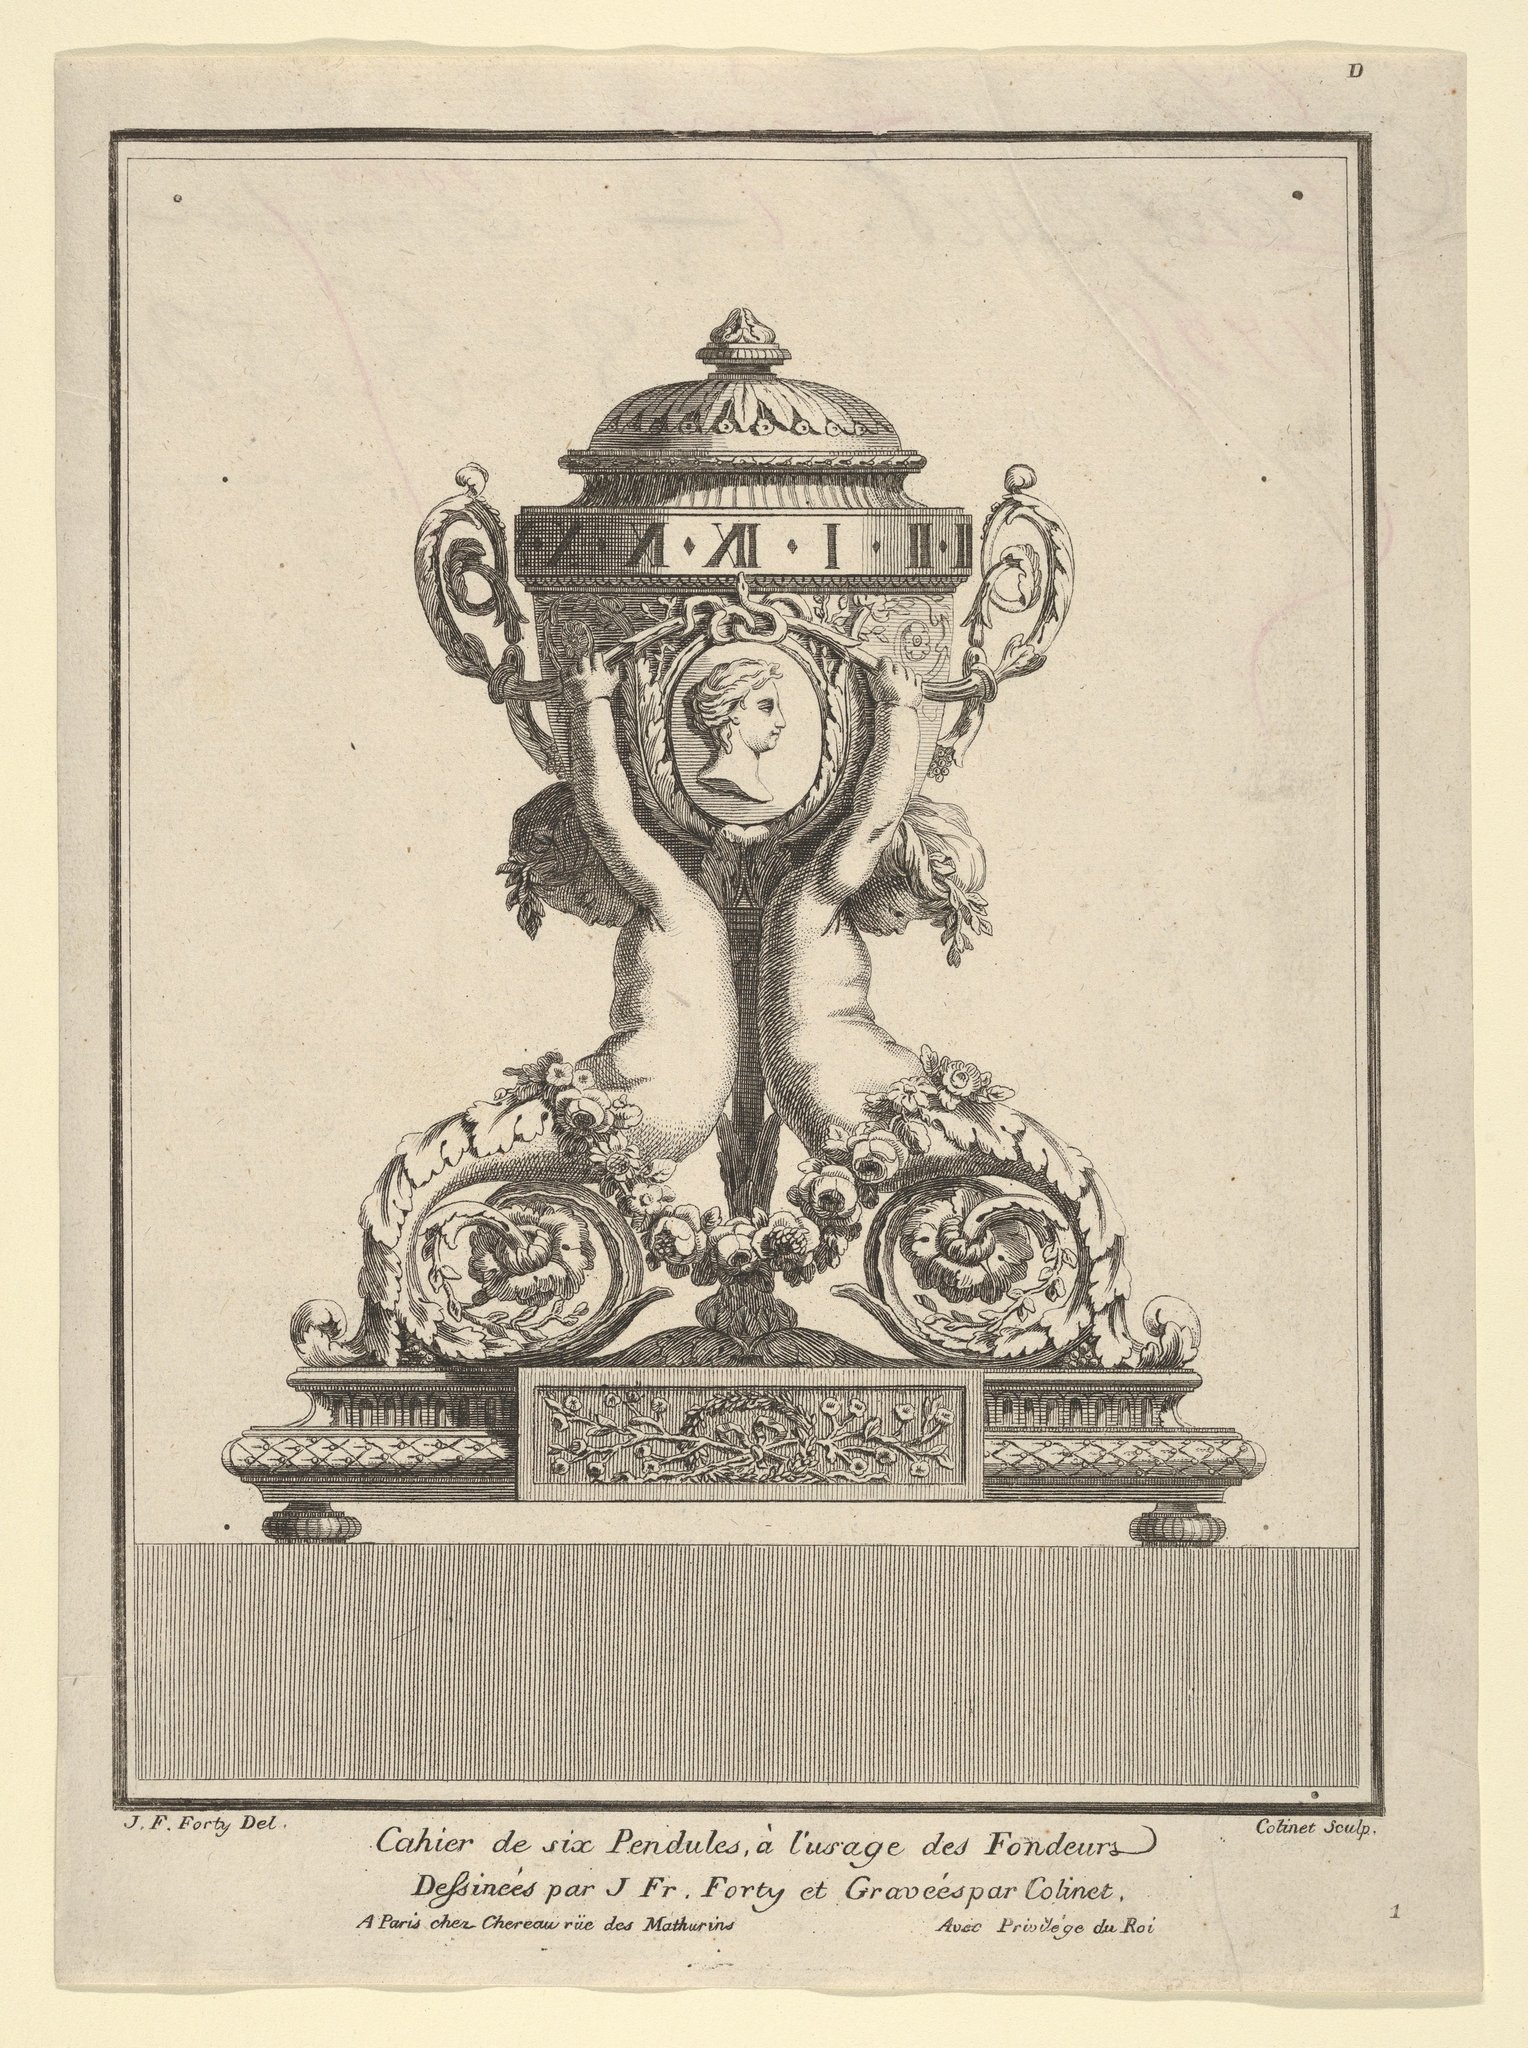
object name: print collection ornament architecture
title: Design for a Clock, Title Page to 'Cahier de six Pendules'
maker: jean françois forty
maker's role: artist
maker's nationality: french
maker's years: 1775-1790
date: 1770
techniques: etching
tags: profiles,women